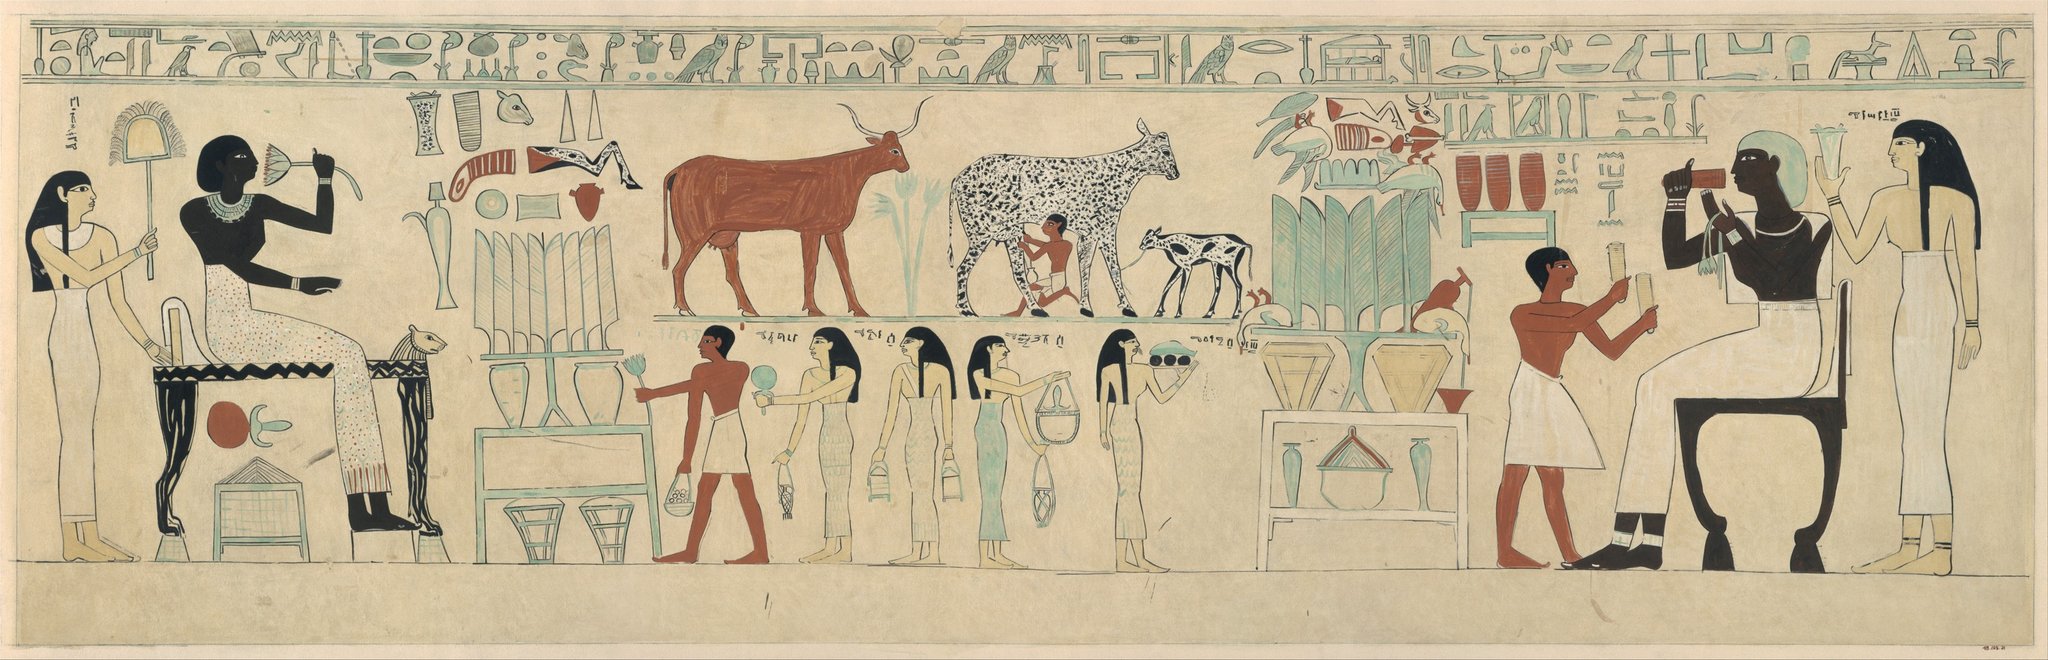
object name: facsimile, aashyt sarcophagus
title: Facsimile of the painting on the inner back side of the sarcophagus of Aashyt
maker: charles k. wilkinson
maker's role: artist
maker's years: 1897-1986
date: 2051-2030 BCE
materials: paper, paint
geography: egypt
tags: animals,women,sarcophagus